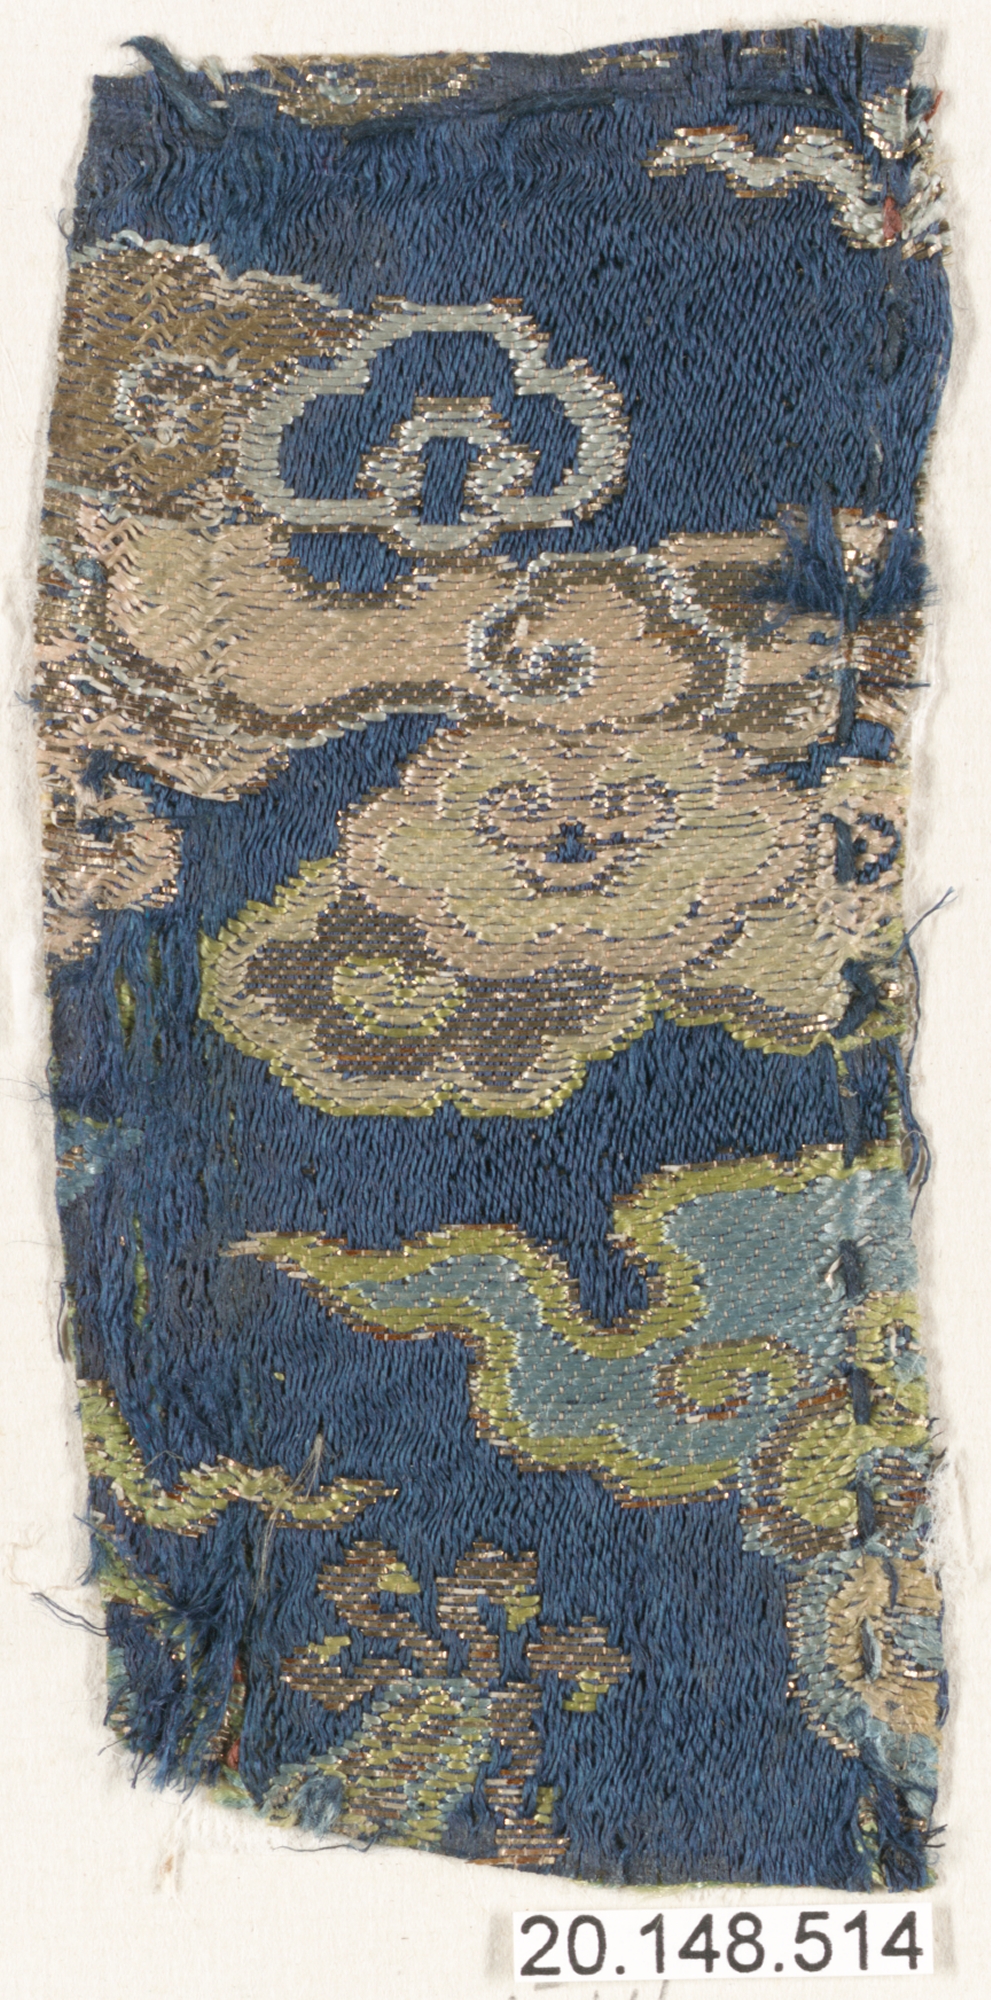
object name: piece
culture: japanese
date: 1701-1800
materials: silk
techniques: compound weave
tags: clouds